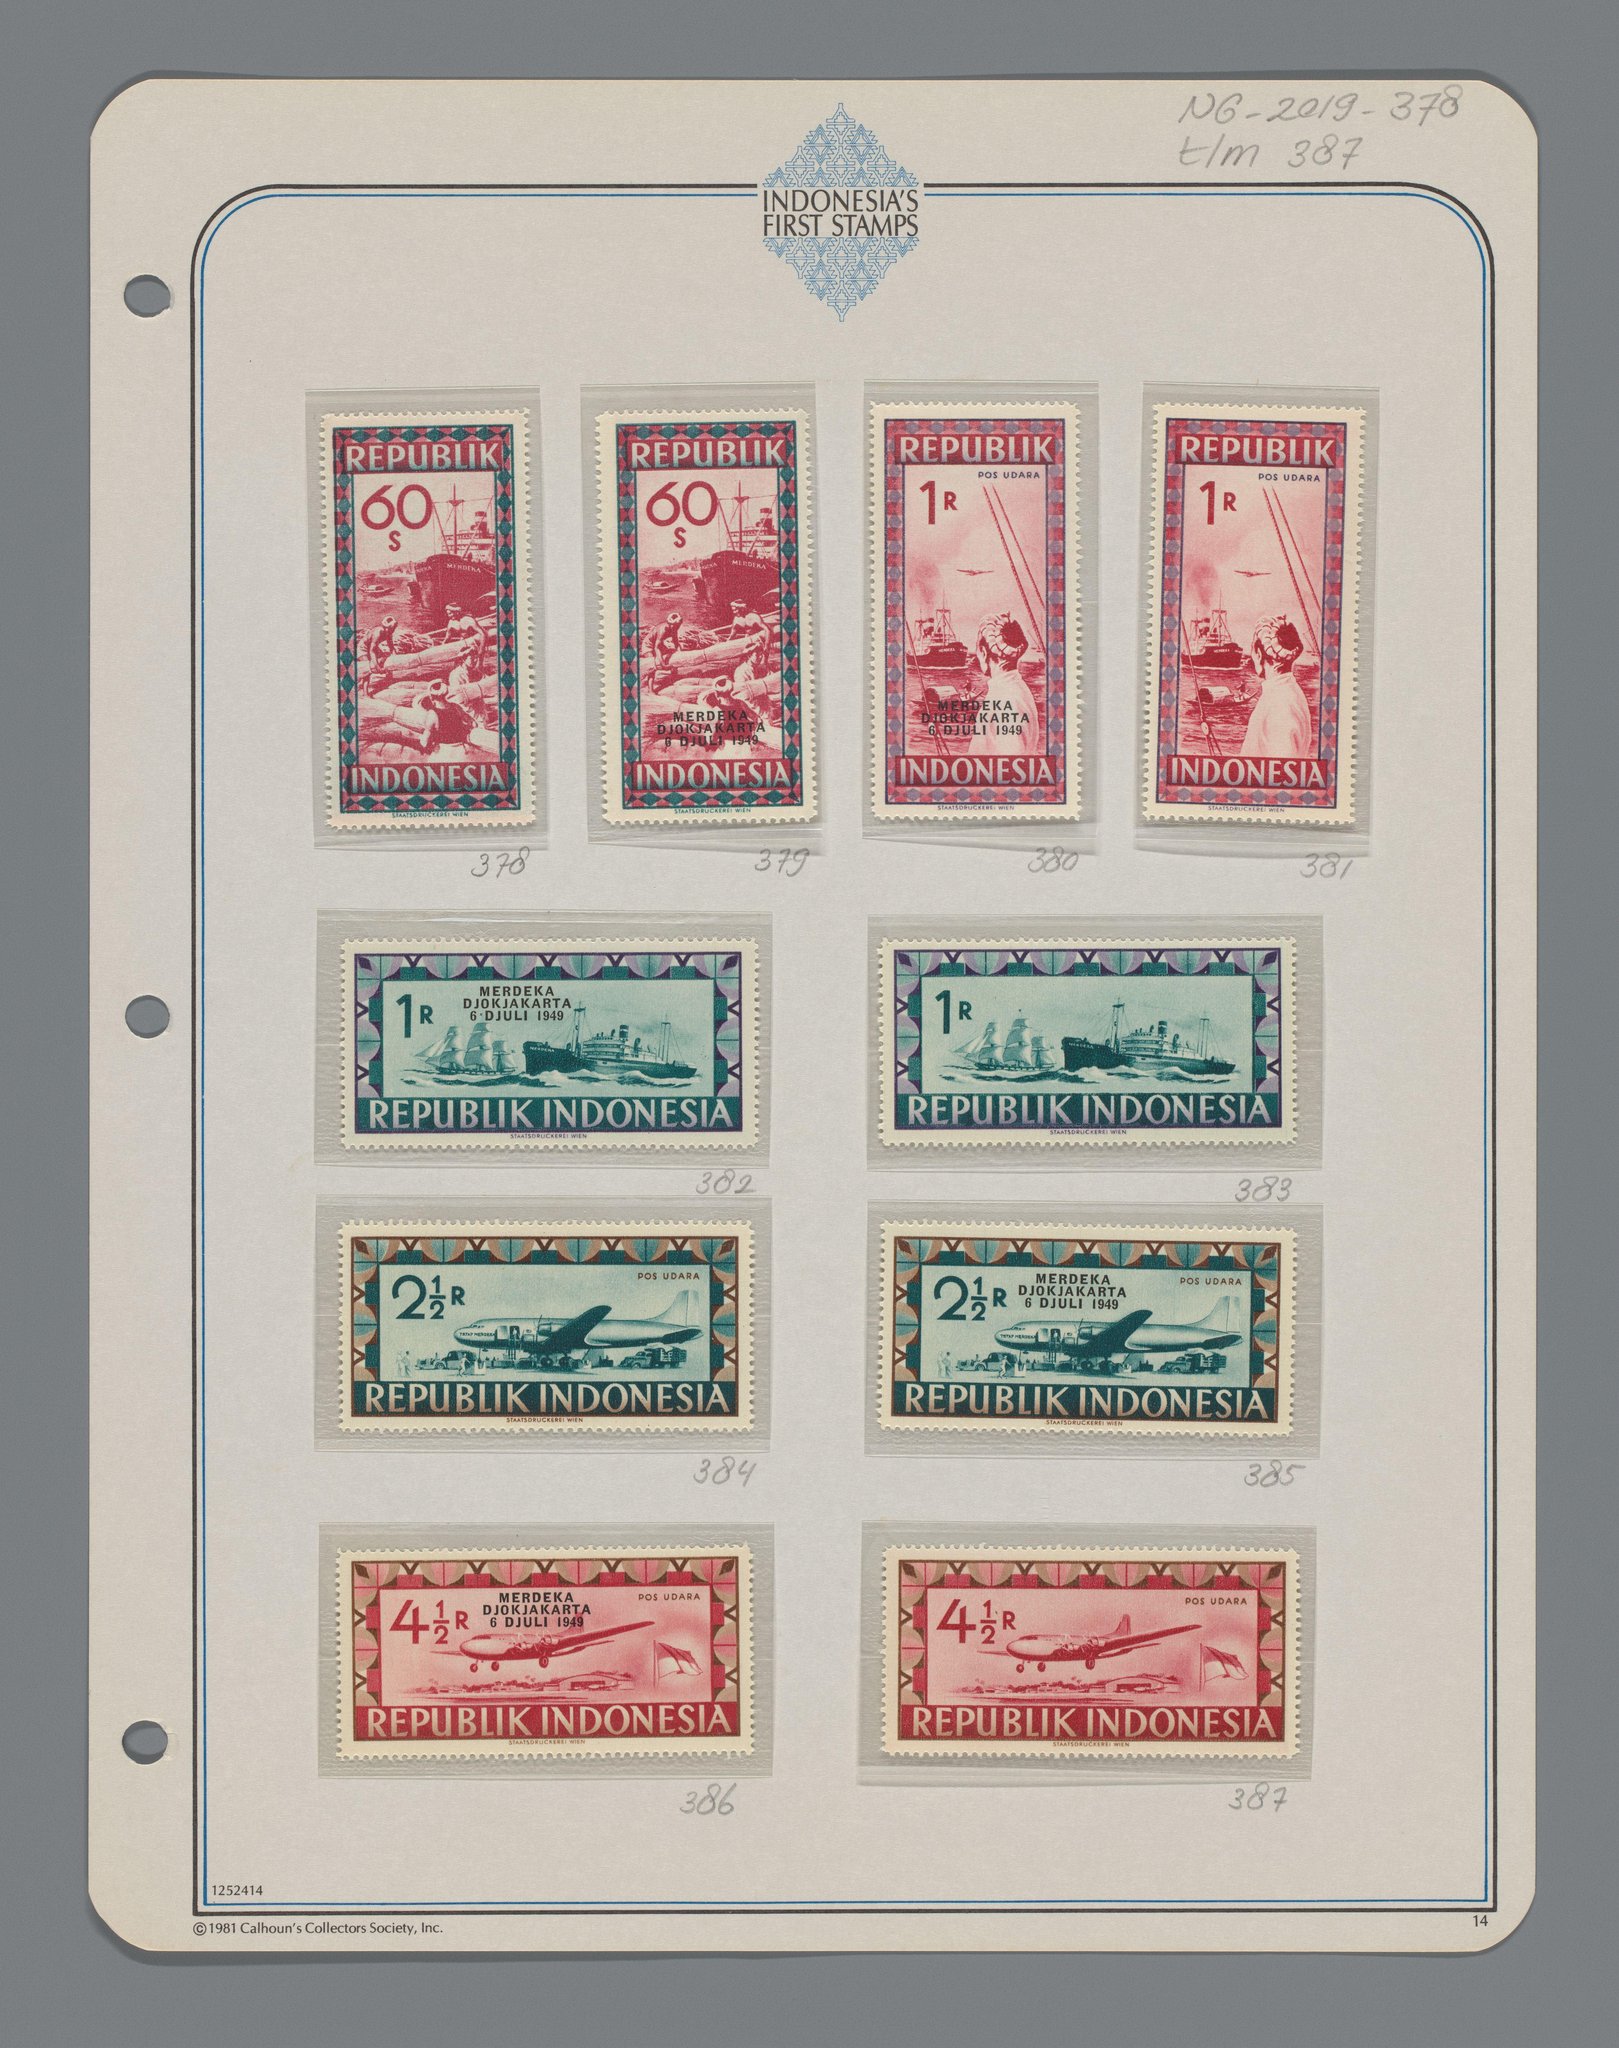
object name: postage stamp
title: Postzegel Republik Indonesia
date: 1949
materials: paper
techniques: photoaquatint, engraving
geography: philadelphia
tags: indonesia